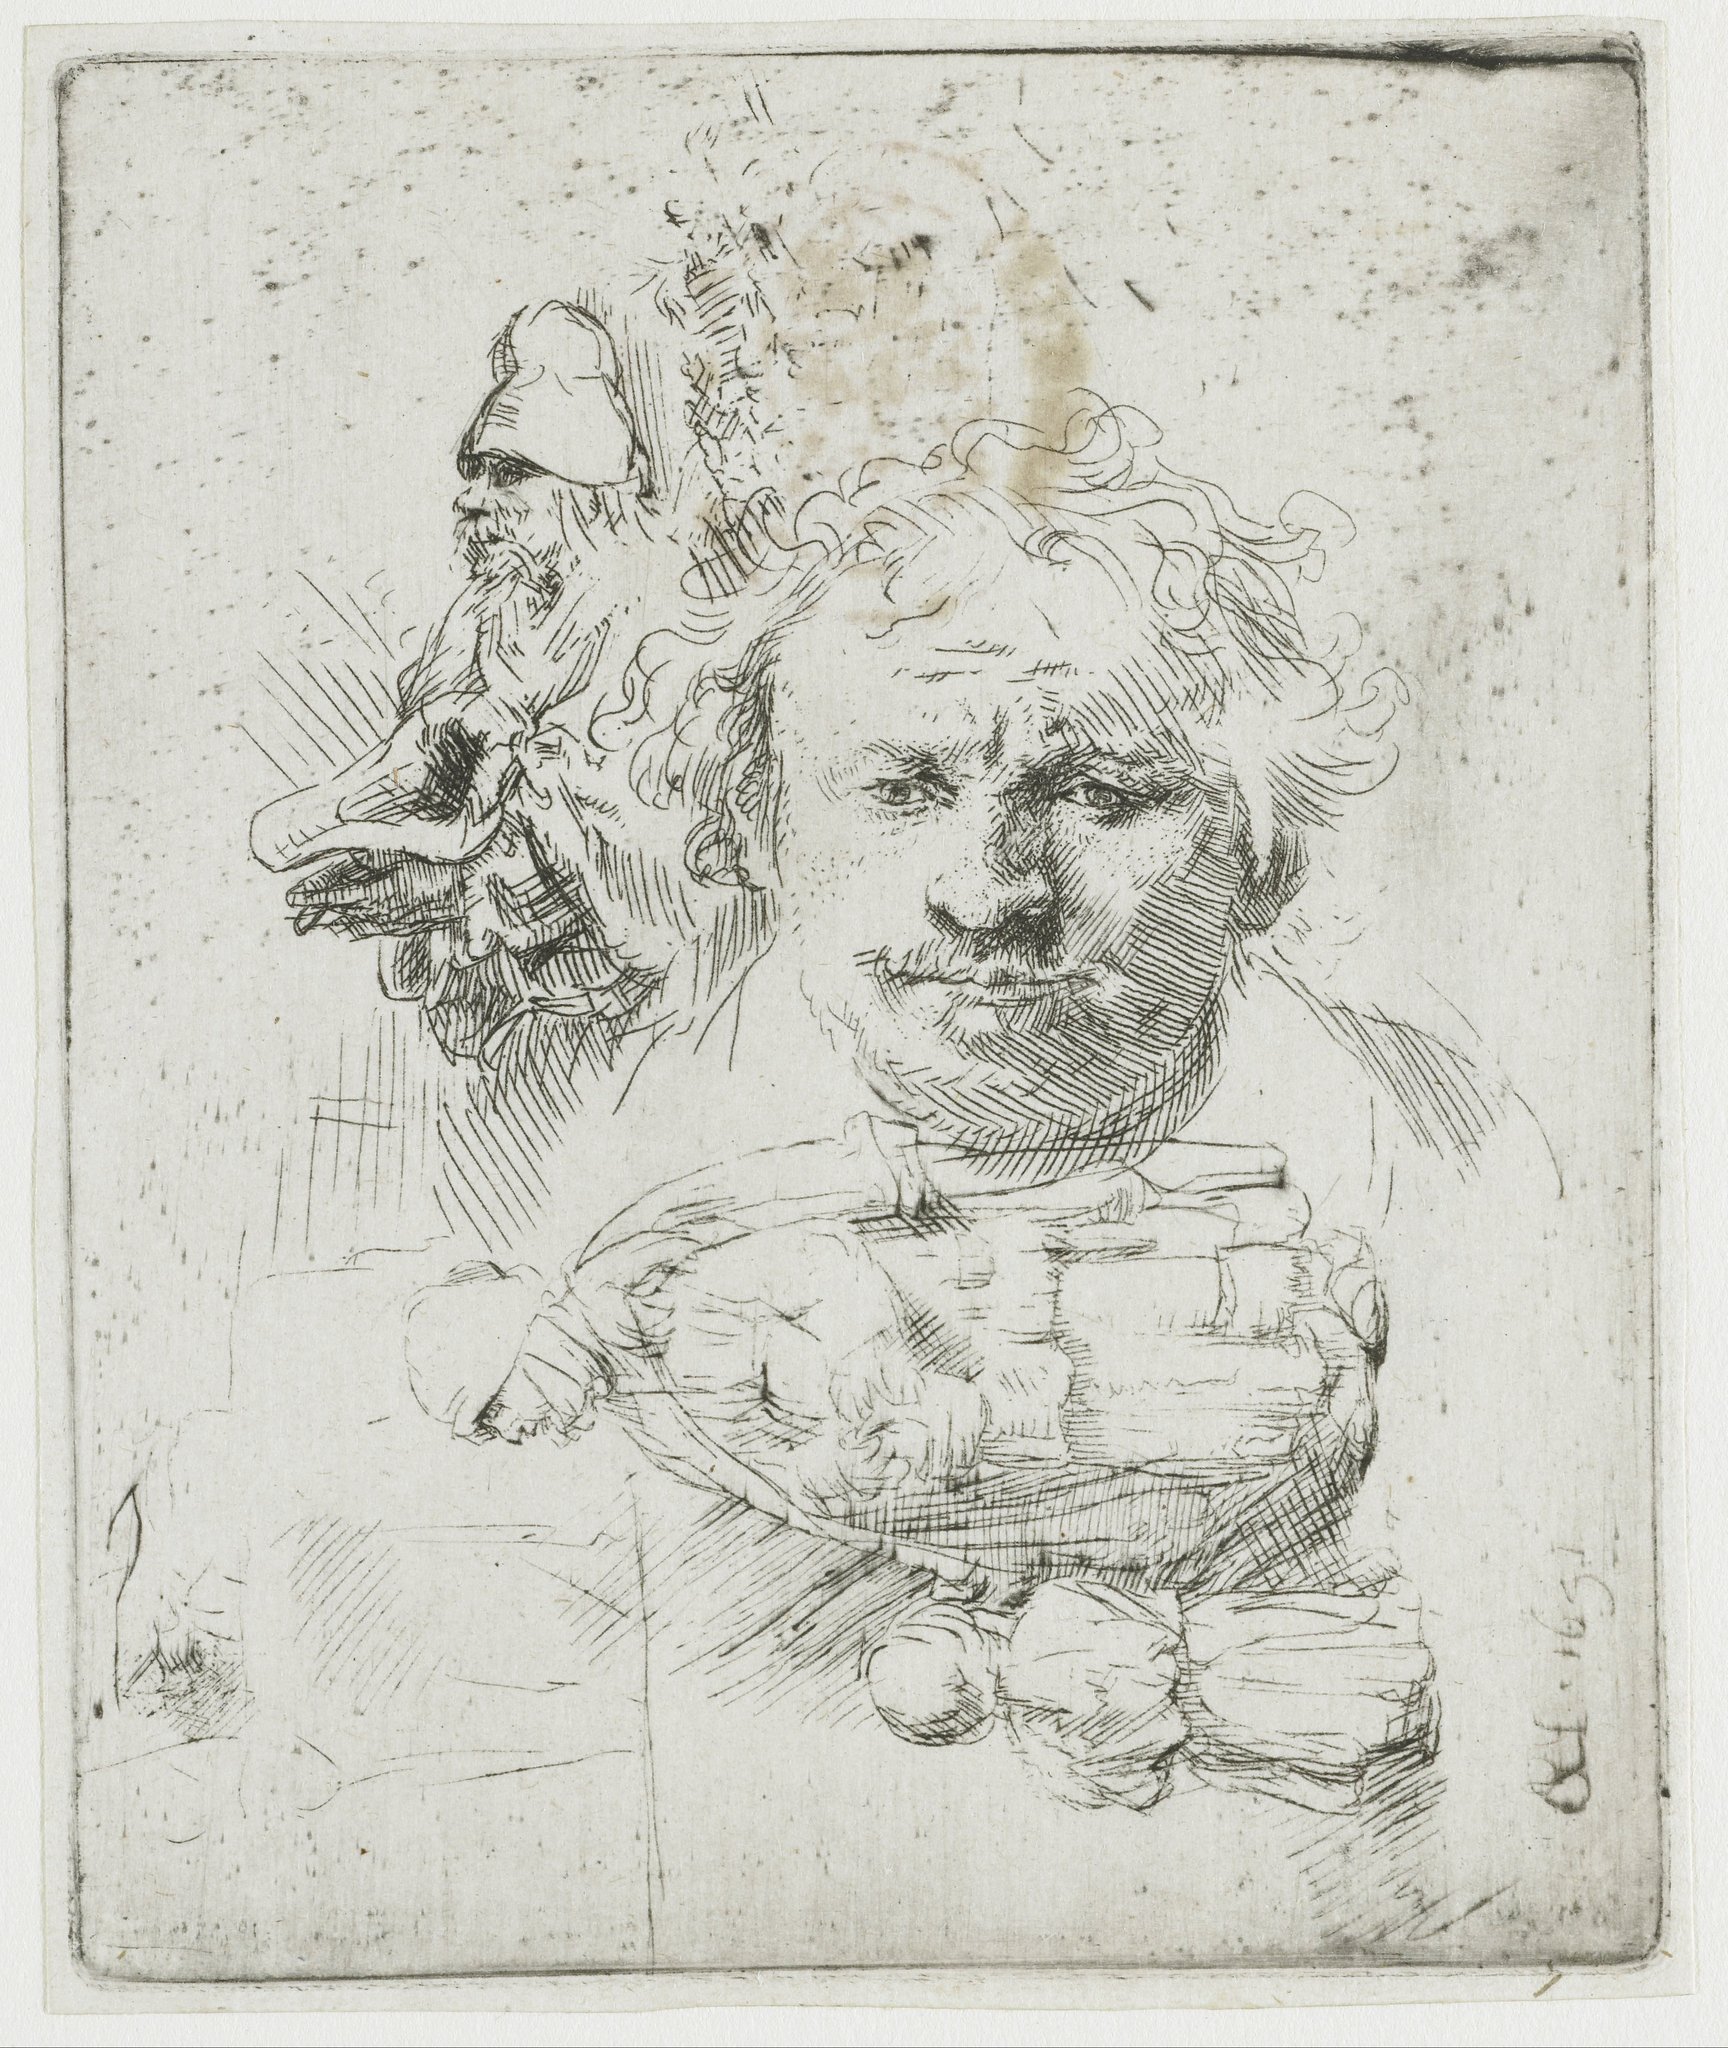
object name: print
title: Sheet of studies with the head of the artist, a beggar man, woman and child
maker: rembrandt van rijn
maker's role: draughtsman, painter, print maker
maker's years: 1606-1669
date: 1651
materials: paper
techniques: etching, intaglio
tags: leiden, amsterdam, print maker, draughtsman, rembrandt van rijn, beggar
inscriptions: monogram and date: ‘RHL 1651’, collector's mark: Lugt 240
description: Rembrandt sometimes used his etching plate as a sketchbook. He would combine unrelated motifs together on a single copperplate. The sequence is unclear, but as each print is rotated, a different motif takes precedence. Also striking is the fact that on each plate he began making a self-portrait, which he then left unfinished.